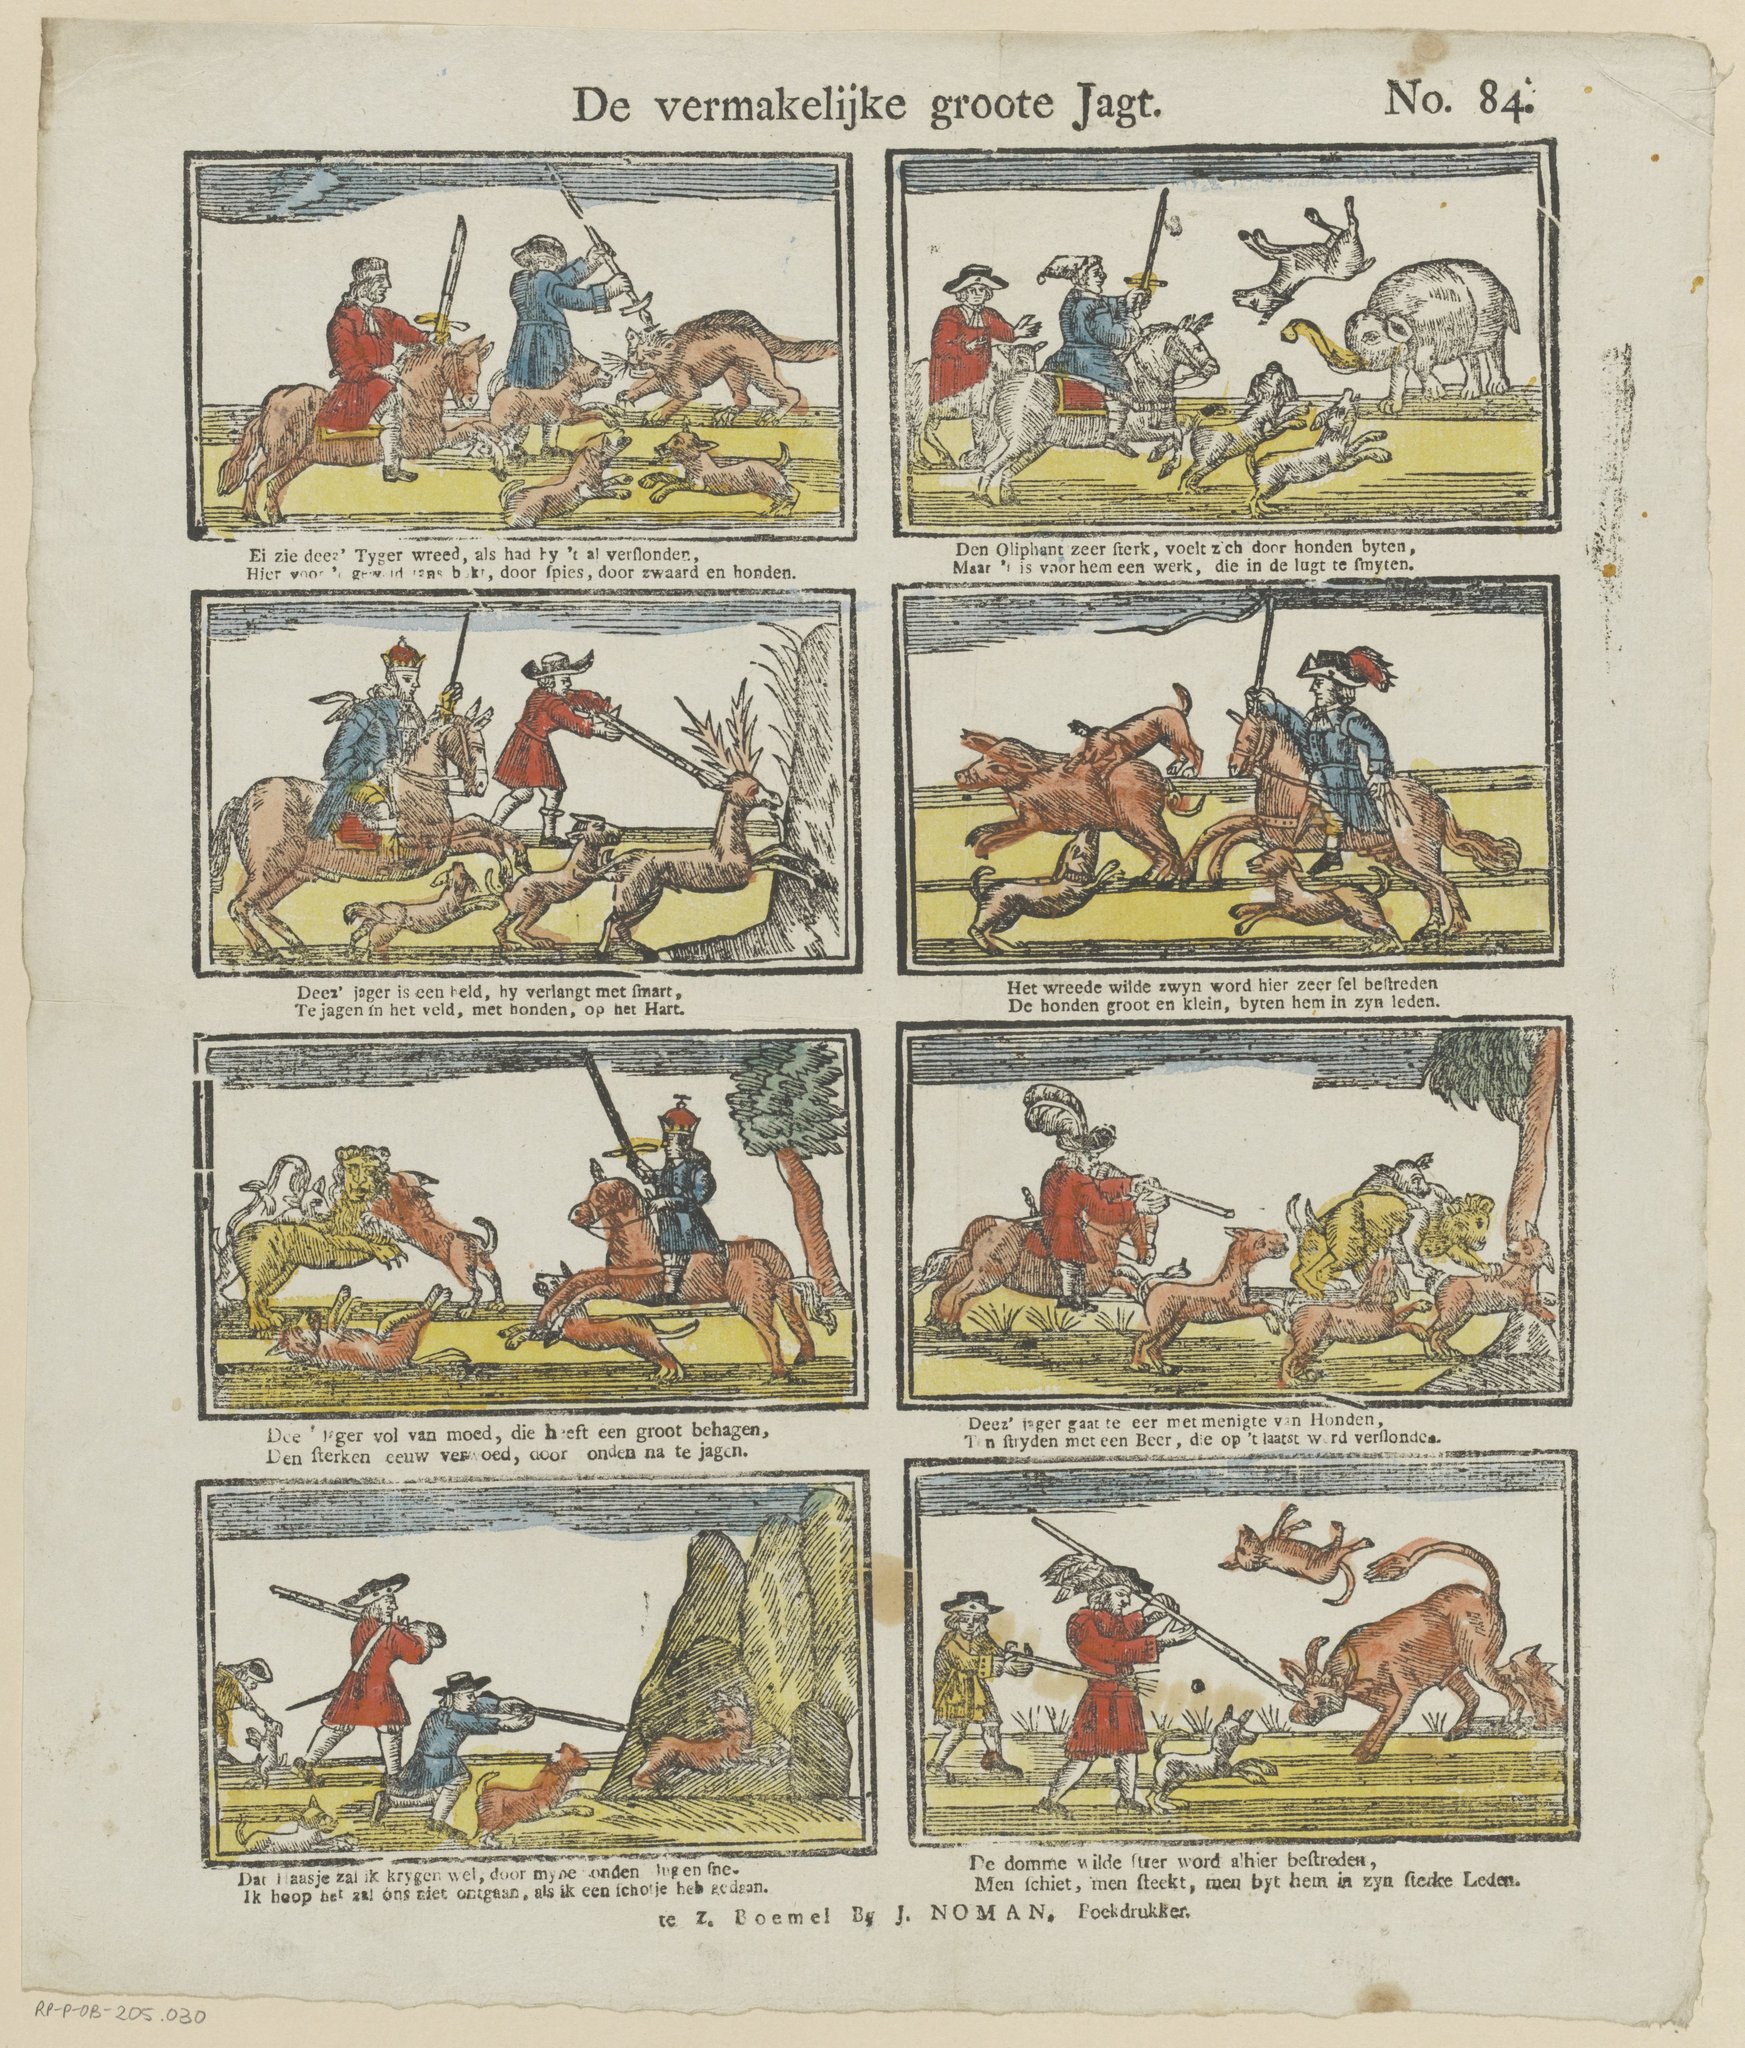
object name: print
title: De vermakelijke groote jagt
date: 1806-1830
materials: paper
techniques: colour, letterpress printing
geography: netherlands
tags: hunters hunting (n.b.: in 1988-1990 this notation denoted the concept of 43c11421 'hunters resting during the hunt'), ruler, sovereign, hunt ~ mammals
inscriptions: collector's mark: Lugt 2760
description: Blad met 8 voorstellingen van vorsten op jacht. Onder elke afbeelding een tweeregelig vers. Genummerd rechtsboven: No. 84.